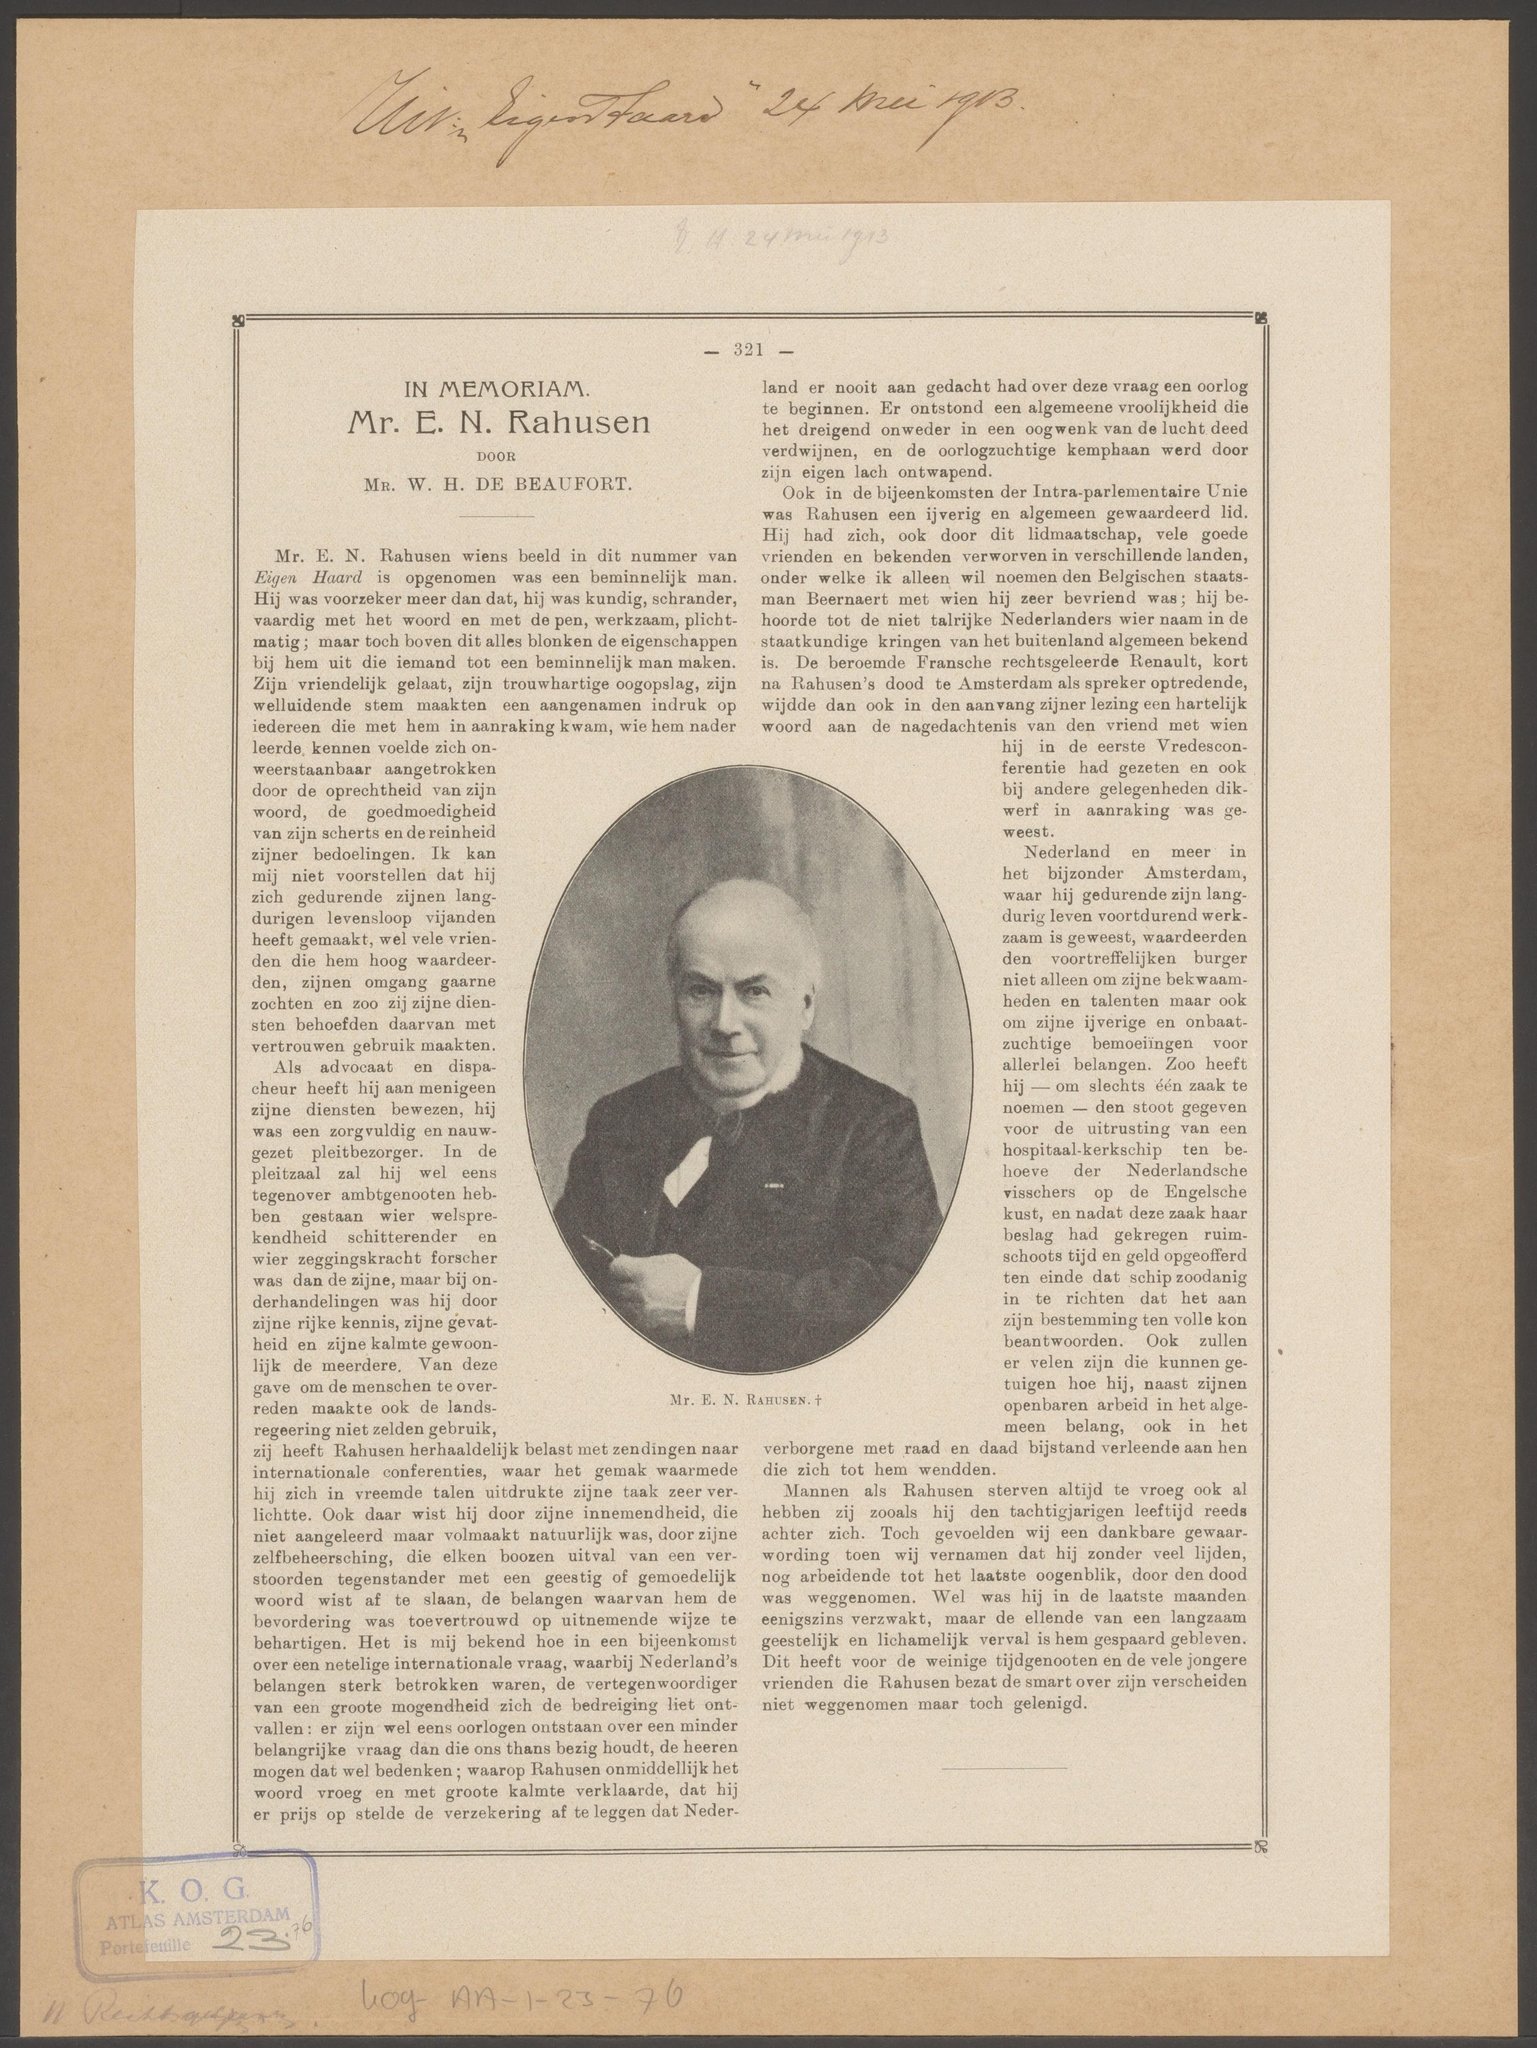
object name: article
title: In memoriam Mr. E.N. Rahusen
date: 1913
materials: paper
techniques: letterpress printing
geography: netherlands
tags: amsterdam, politician, historical persons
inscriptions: collector's mark: Lugt 1641b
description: Prent uit: Eigen Haard 39 (1913), nr. 21, 24 mei 1913, p. 321.